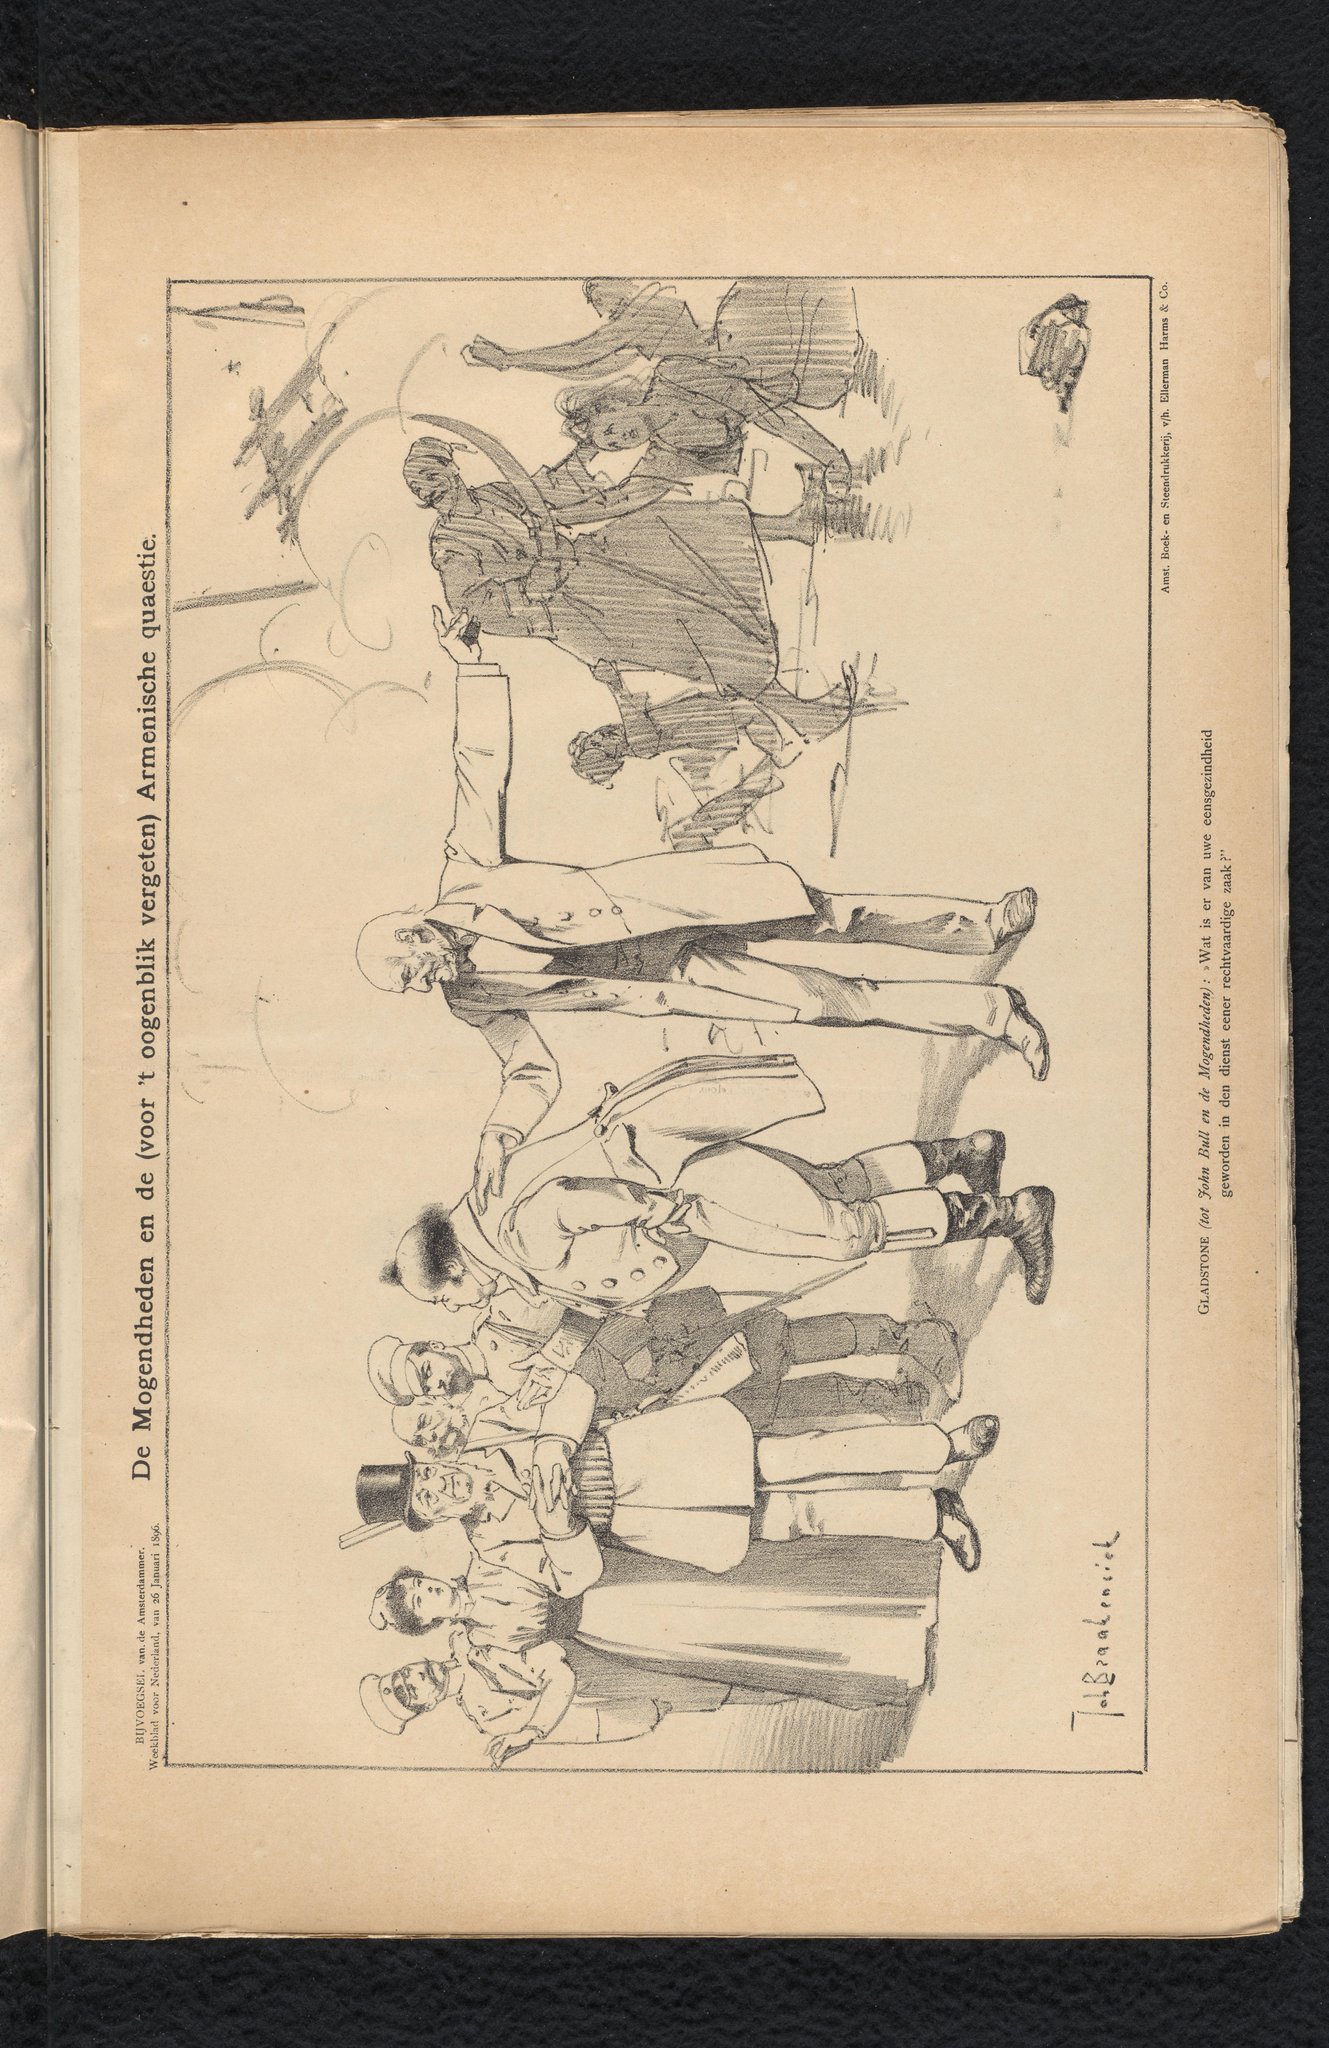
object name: cartoon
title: De Mogendheden en de (voor 't oogenblik vergeten) Armenische quaestie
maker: johan braakensiek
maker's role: draughtsman, print maker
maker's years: 1858-1940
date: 1896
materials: paper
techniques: lithograph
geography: netherlands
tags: wilhelm ii (keizer van duitsland), liverpool, politician, personifications of countries, nations, states, districts, etc., soldiers and civilians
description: Premier Gladstone wijst John Bull (Engeland), Paul Kruger en de Europese landen op de moord op de Armeense bevolking door Ottomaanse soldaten.